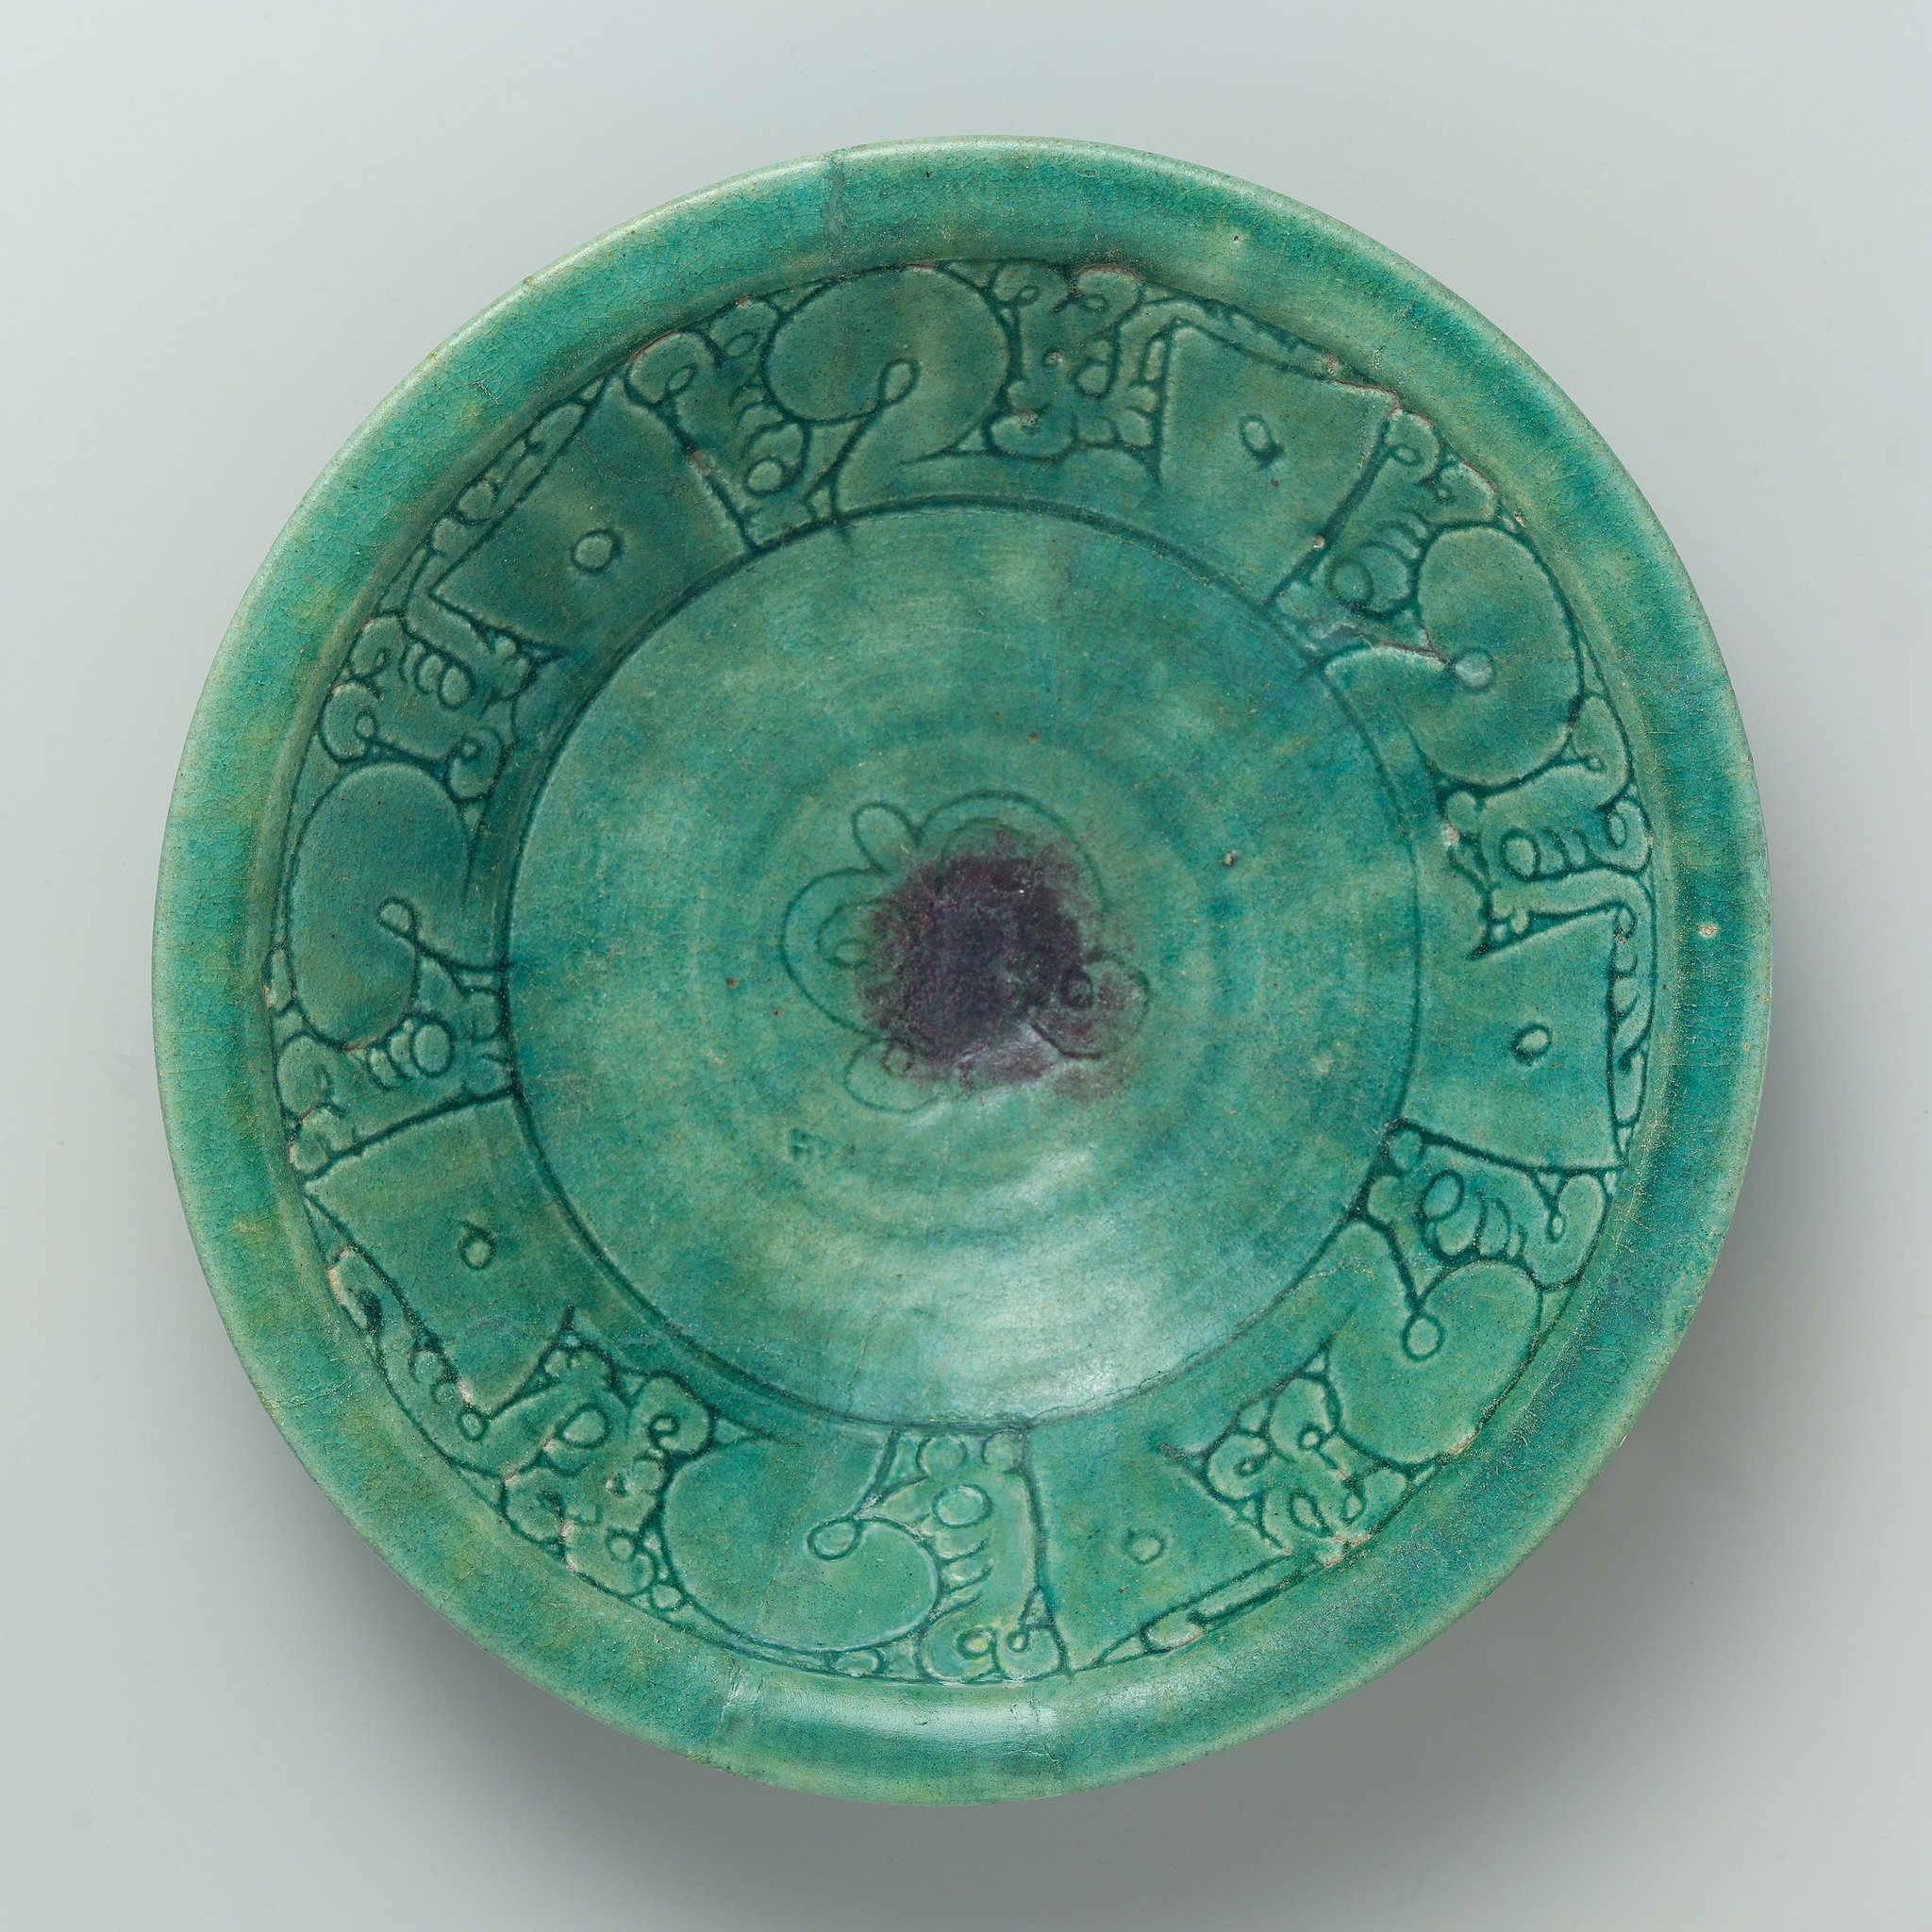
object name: bowl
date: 1001-1200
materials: stonepaste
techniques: glazing, incising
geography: egypt